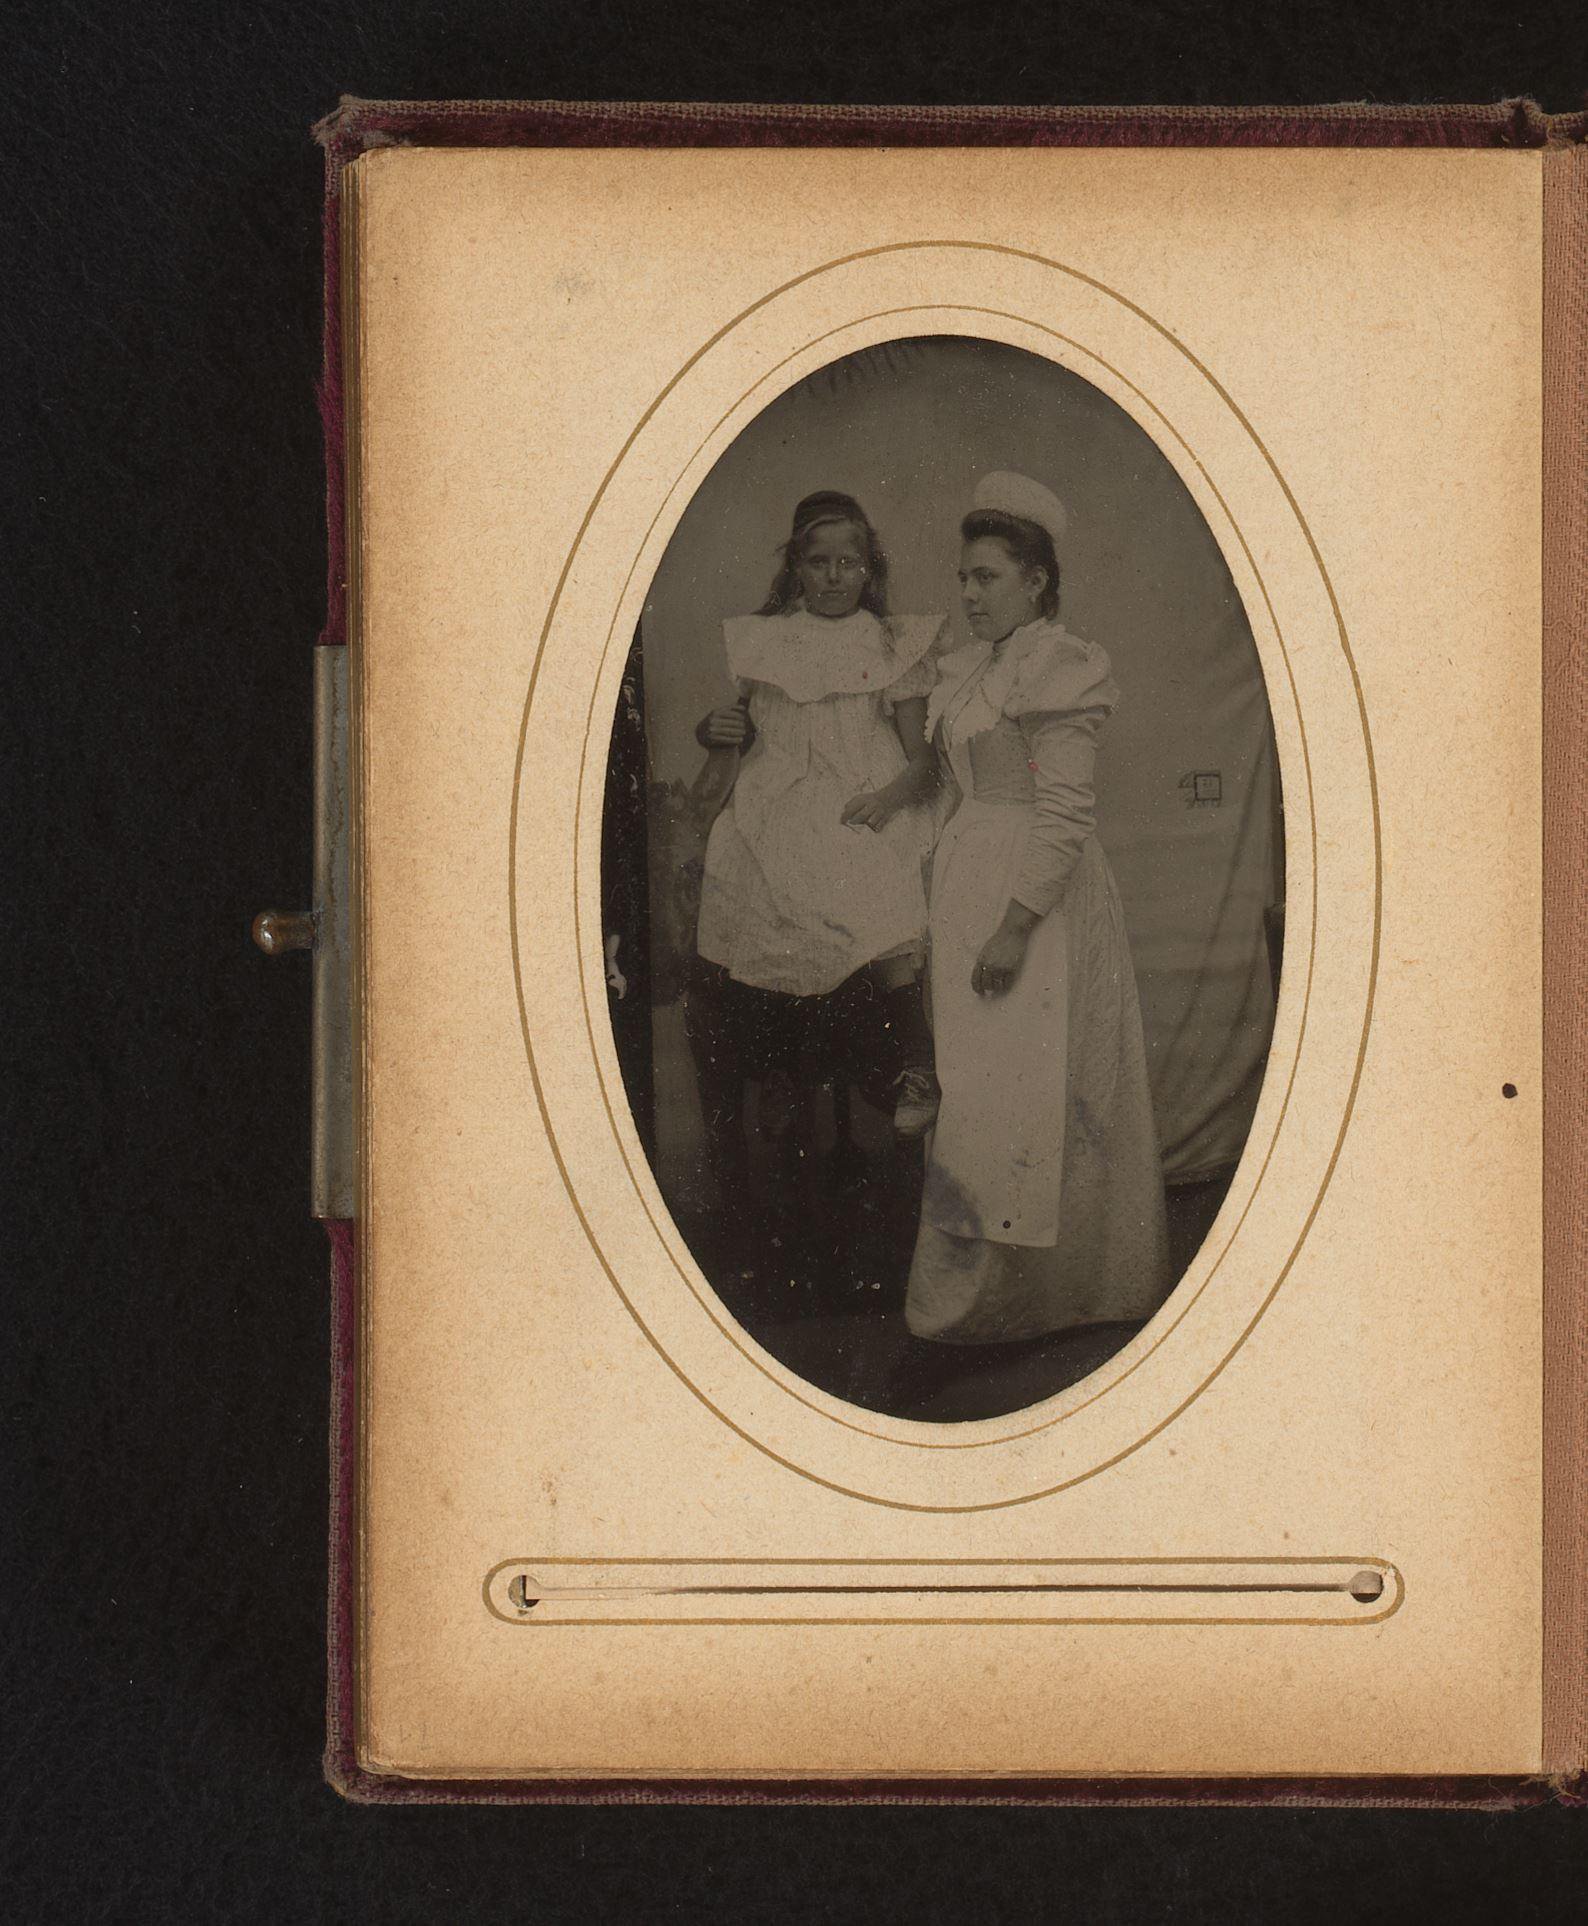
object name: photograph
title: Portret van een meisje en een vrouw, vermoedelijk de kinderjuffrouw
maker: Anonymous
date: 1870-1882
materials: iron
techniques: ferrotyping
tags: adult man, historical persons, girl (child between toddler and youth)